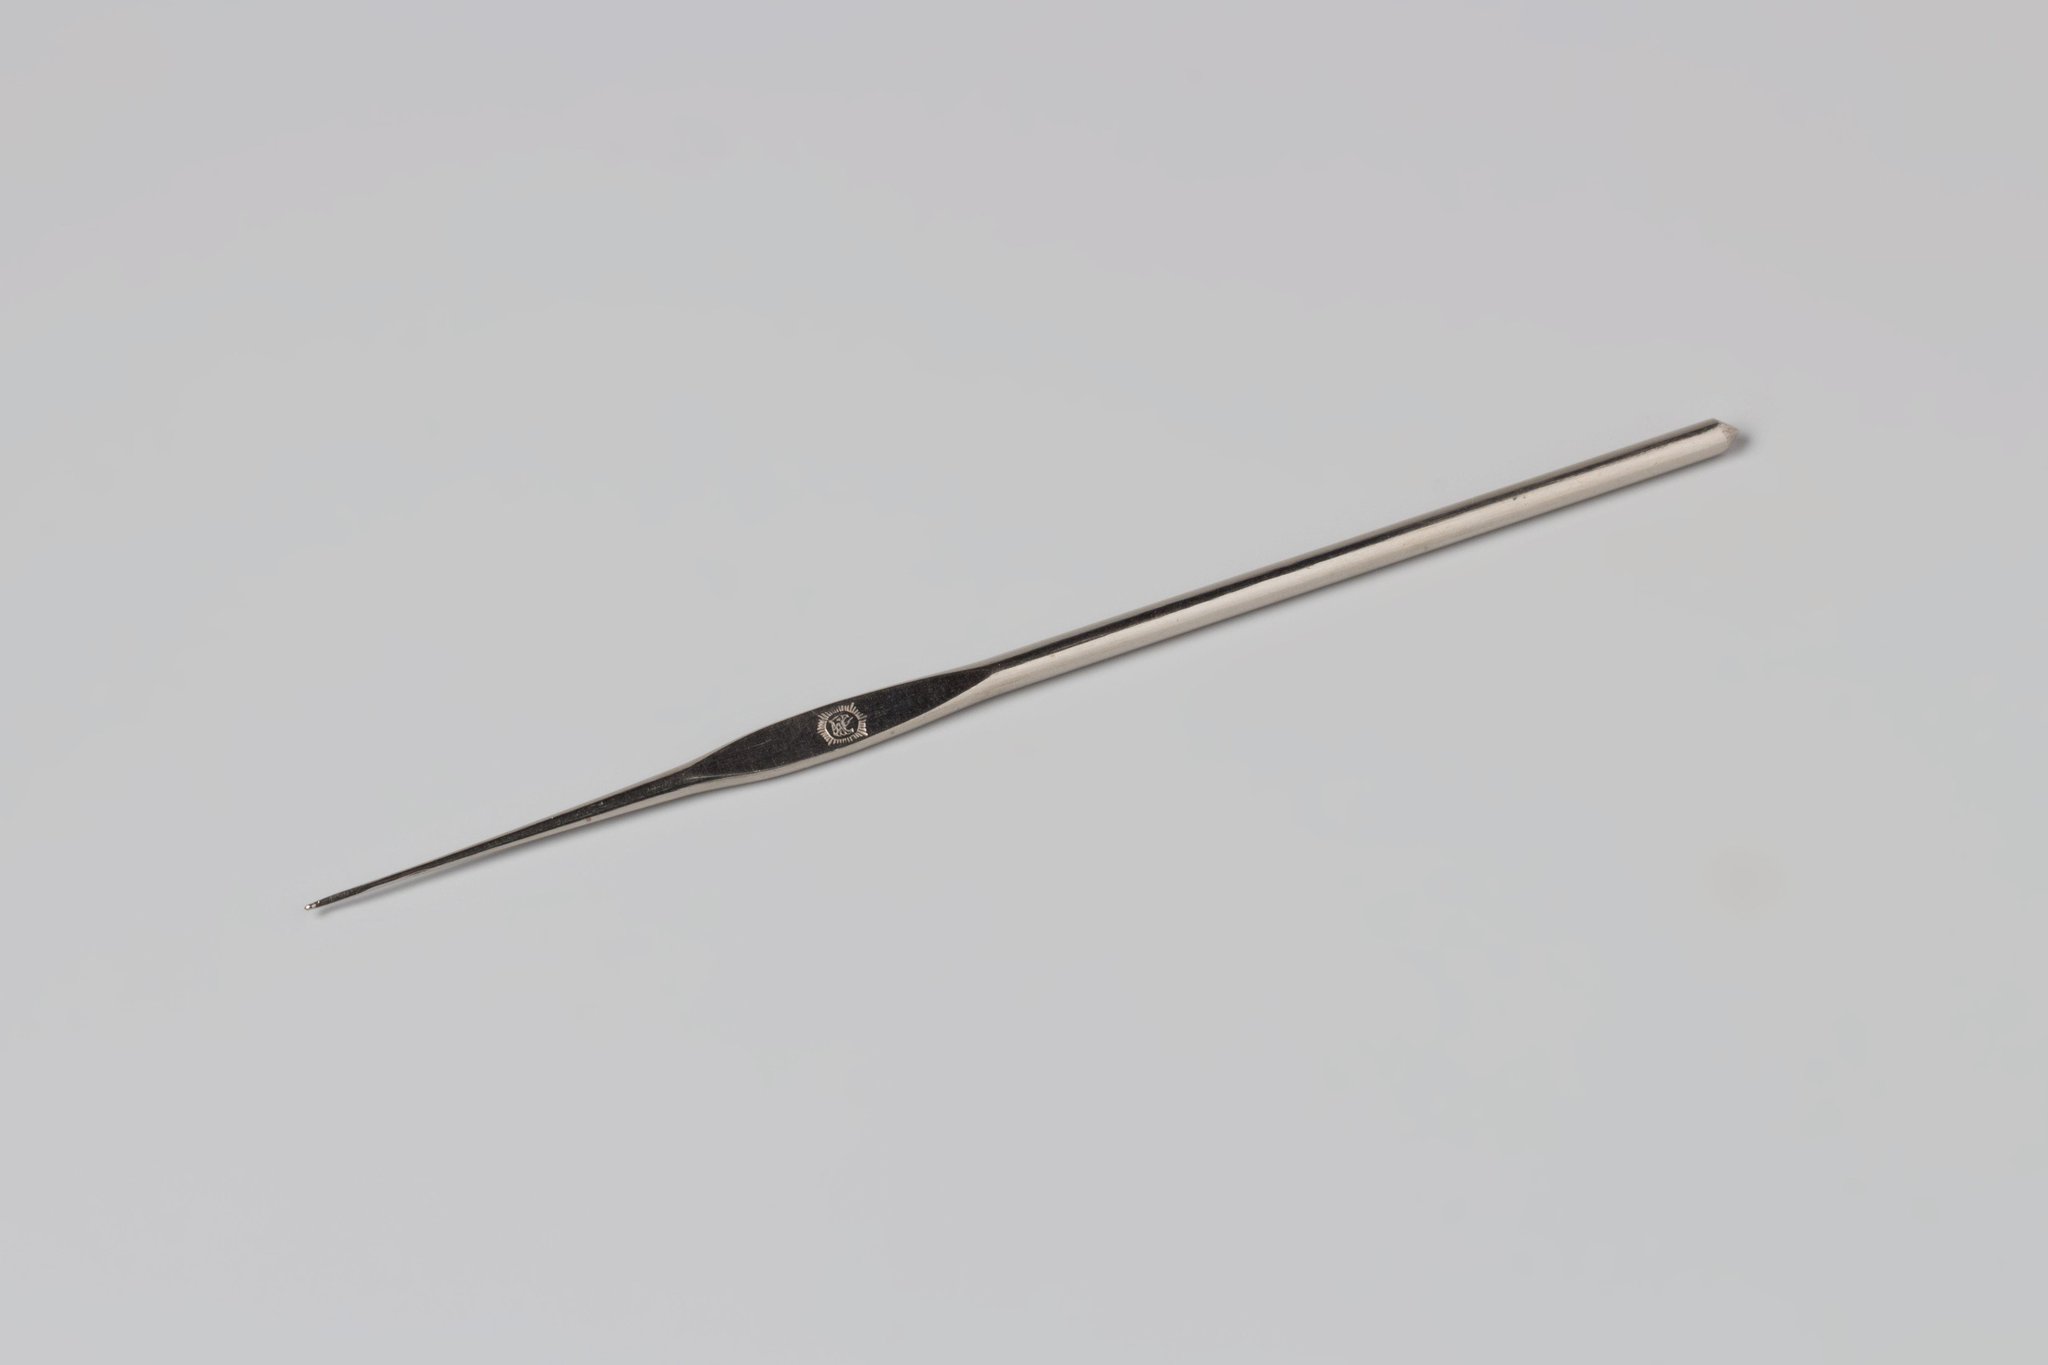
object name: textile working equipment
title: Haakpen van staal met afgeplat handvat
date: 1900-1950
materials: steel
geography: germany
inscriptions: number: ‘'11'’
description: Een haakpen van staal met afgeplat handvat. Adres: Imra / Geschützt.